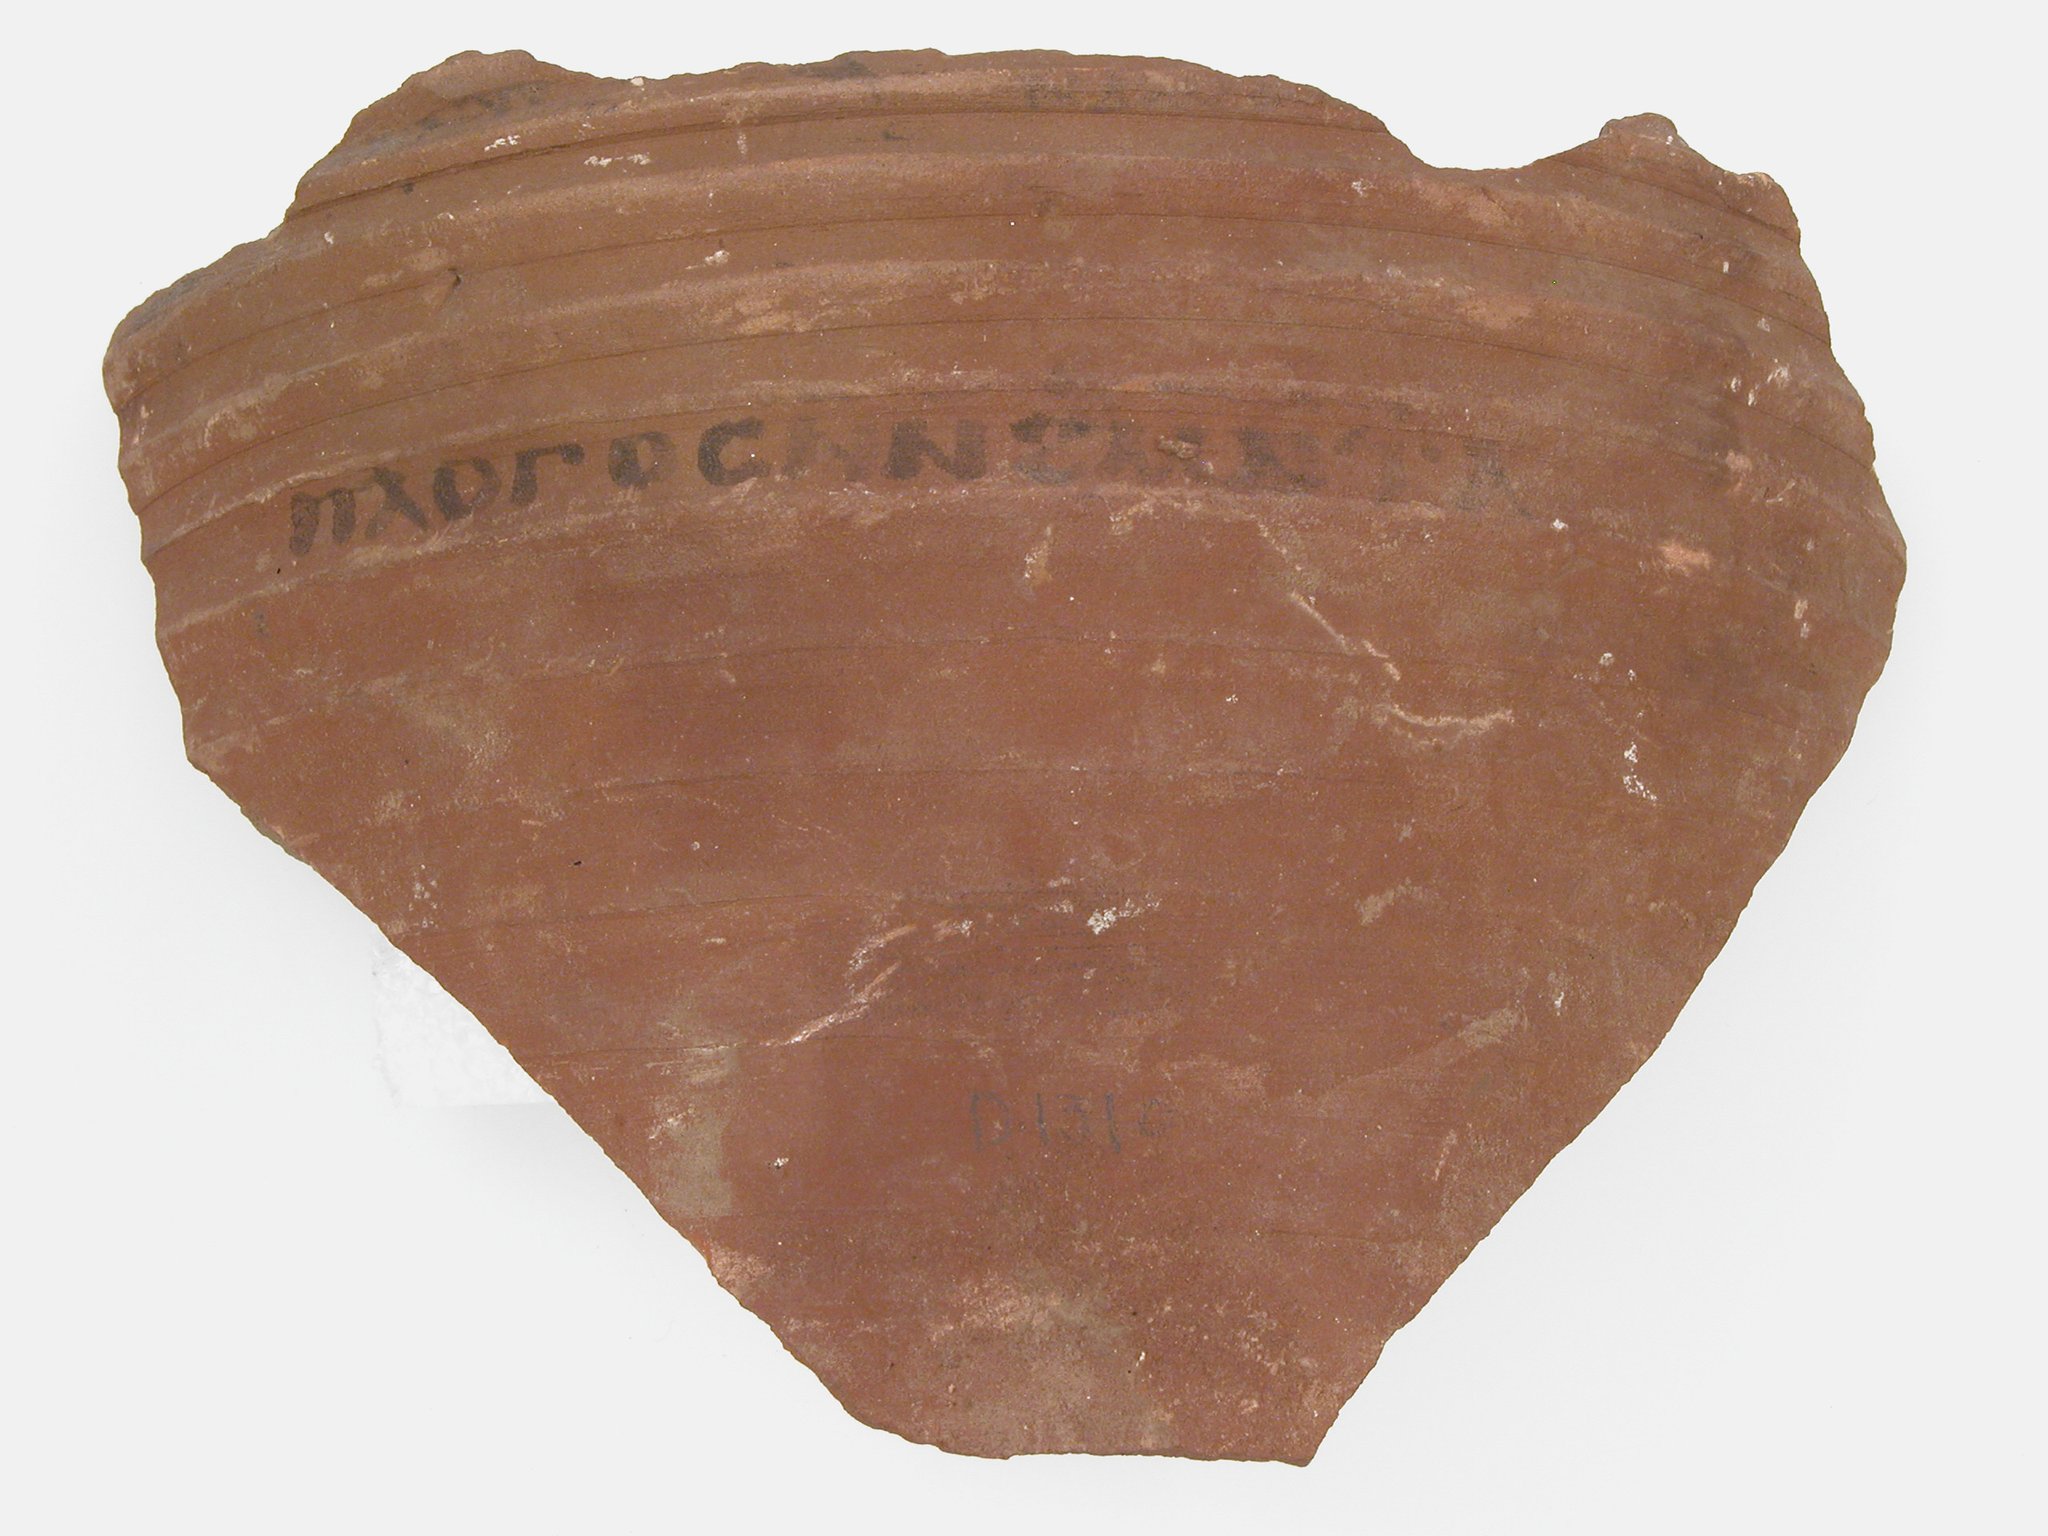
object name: ostrakon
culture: coptic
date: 601-700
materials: ink, pottery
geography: egypt